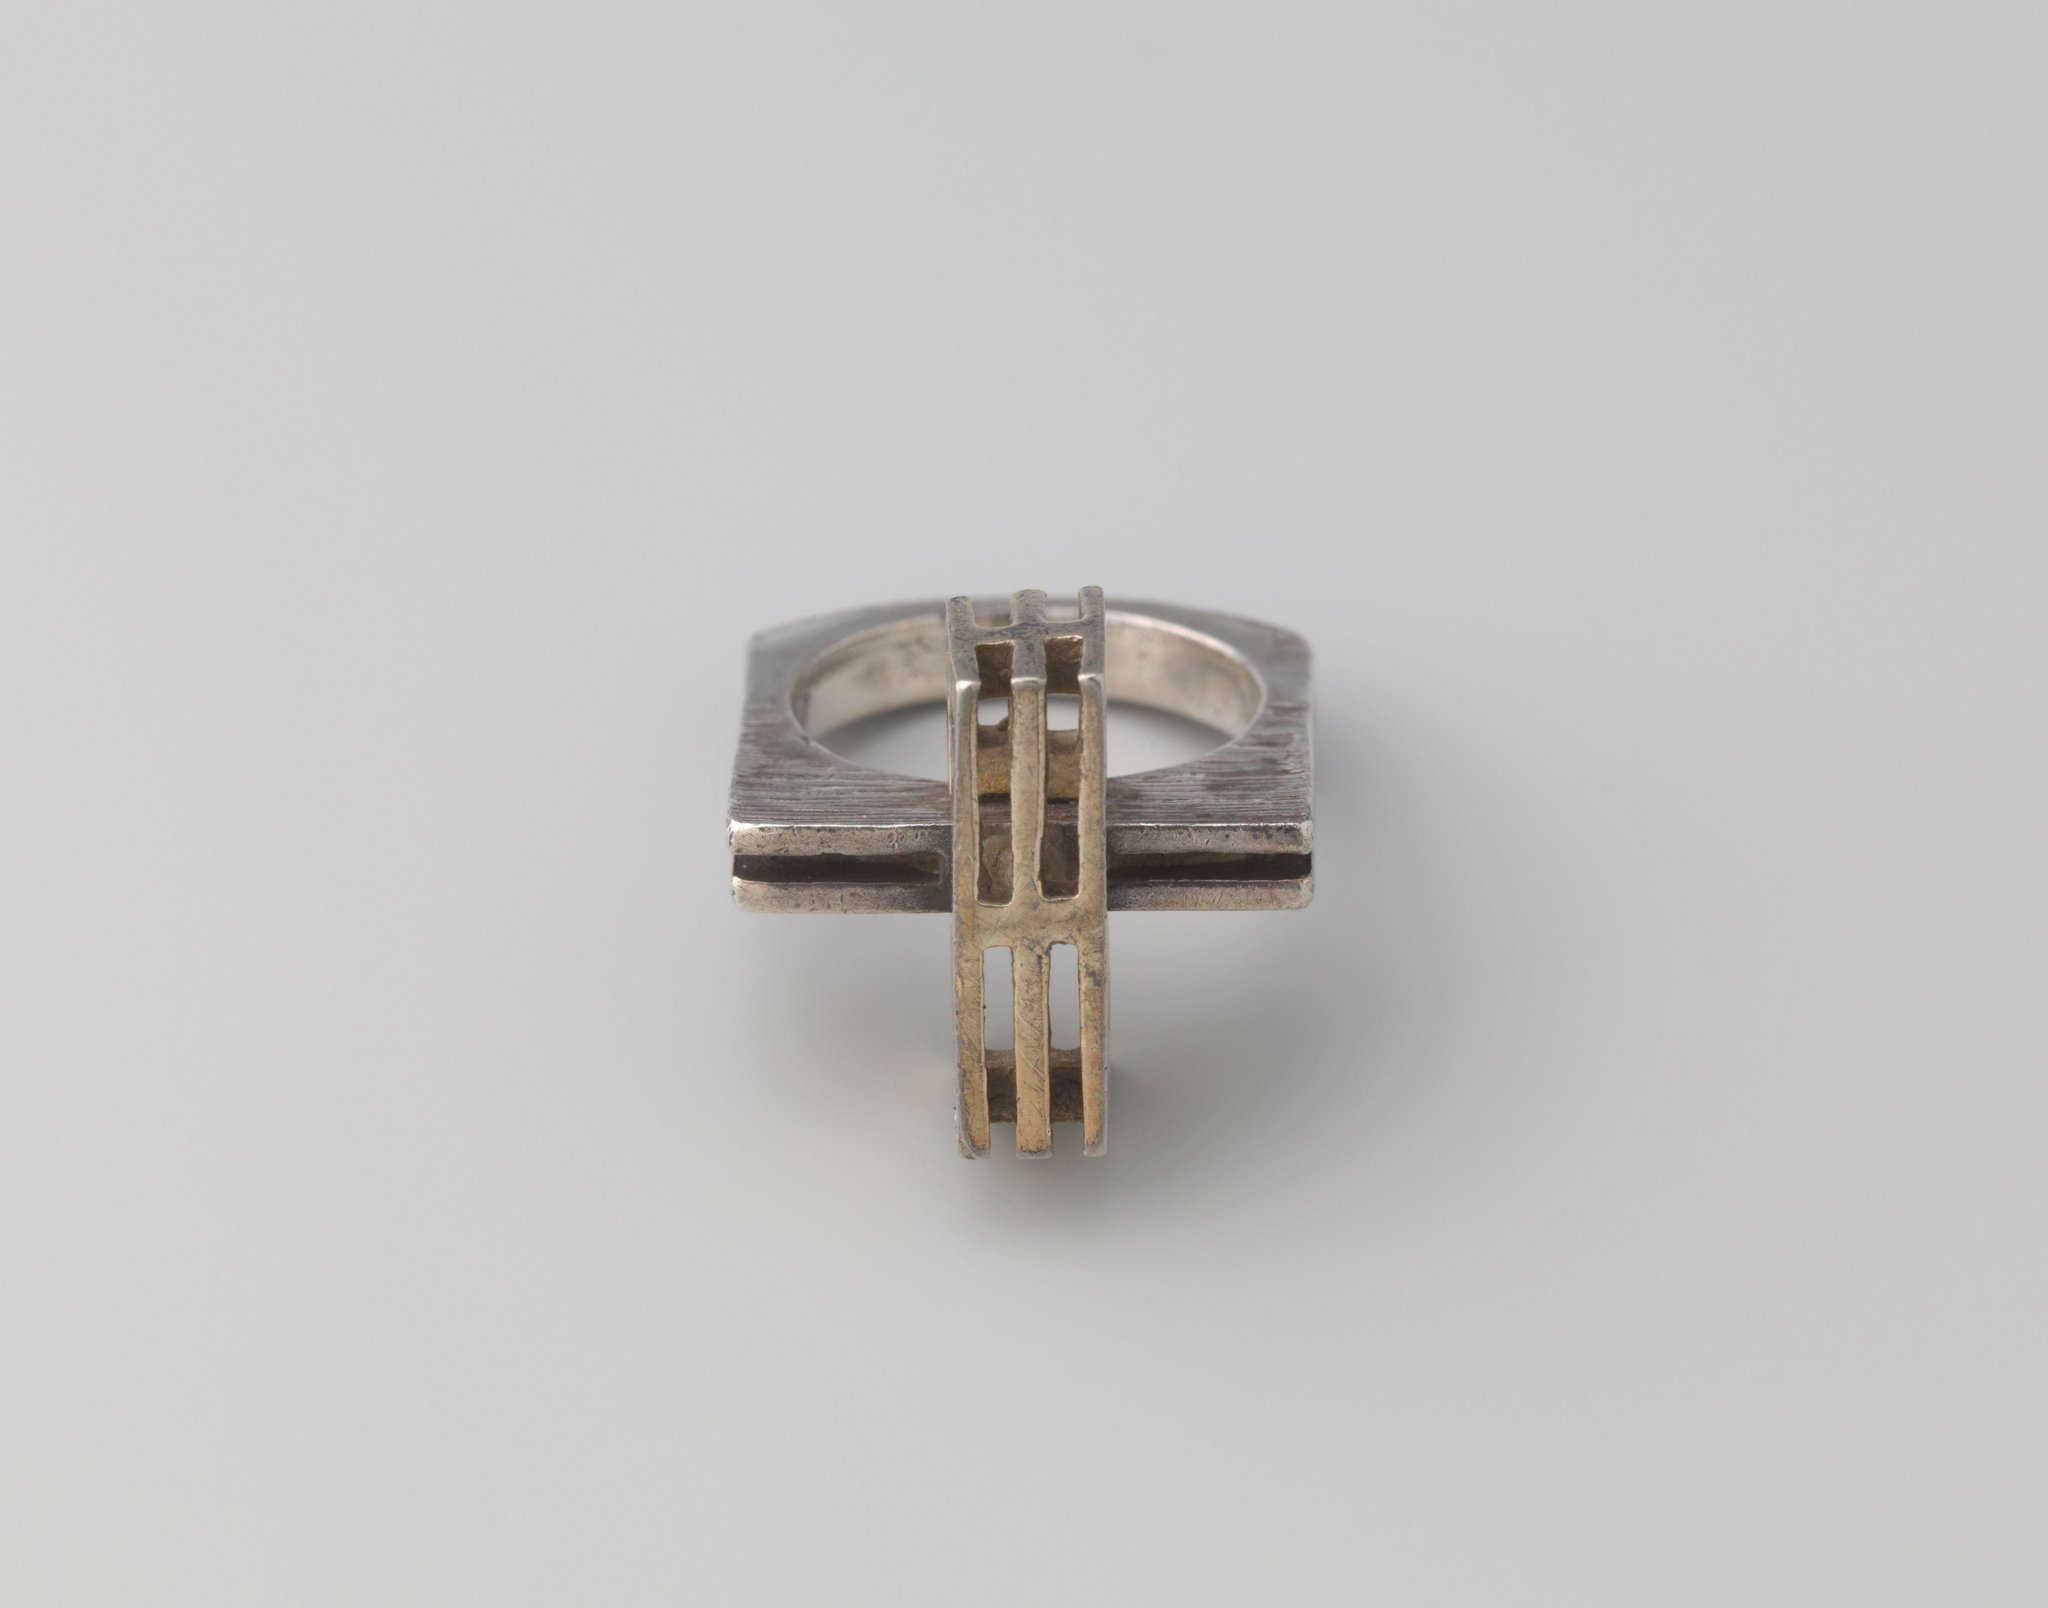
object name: ring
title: Tienerring van zilver met rechthoekige ajour vergulde schakel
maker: Anonymous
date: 1960-1970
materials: silver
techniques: gilding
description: Tienerring van zilver met rechthoekige ajour vergulde schakel.